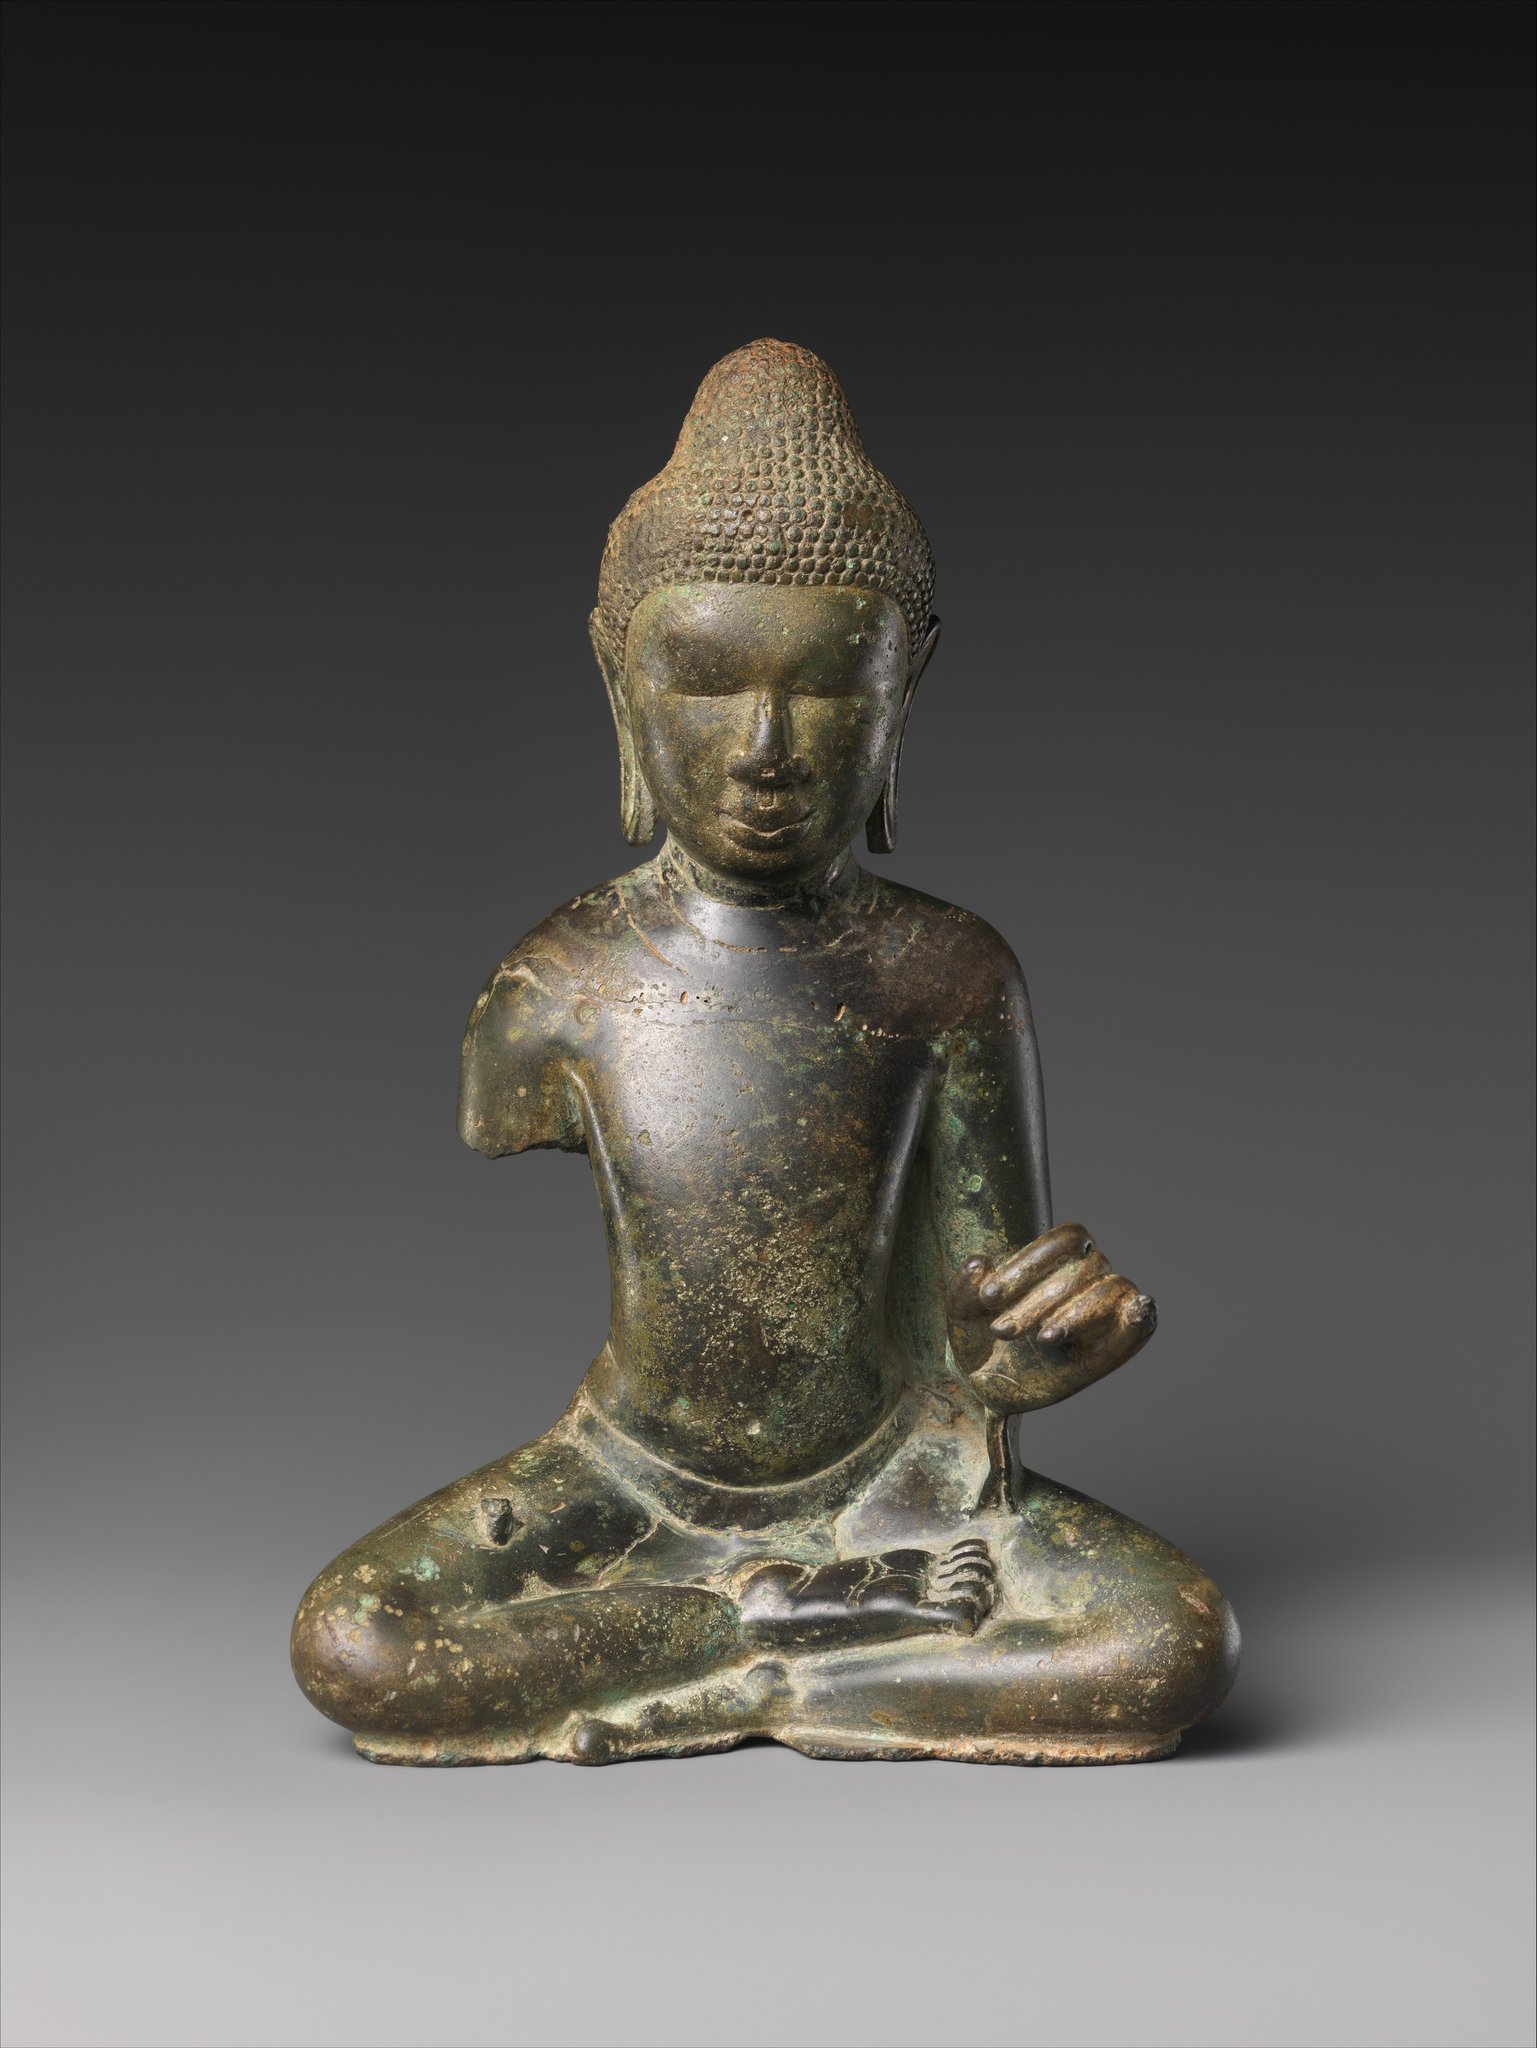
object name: figure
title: Seated Buddha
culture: burmese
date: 701-833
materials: bronze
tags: buddhism,buddha